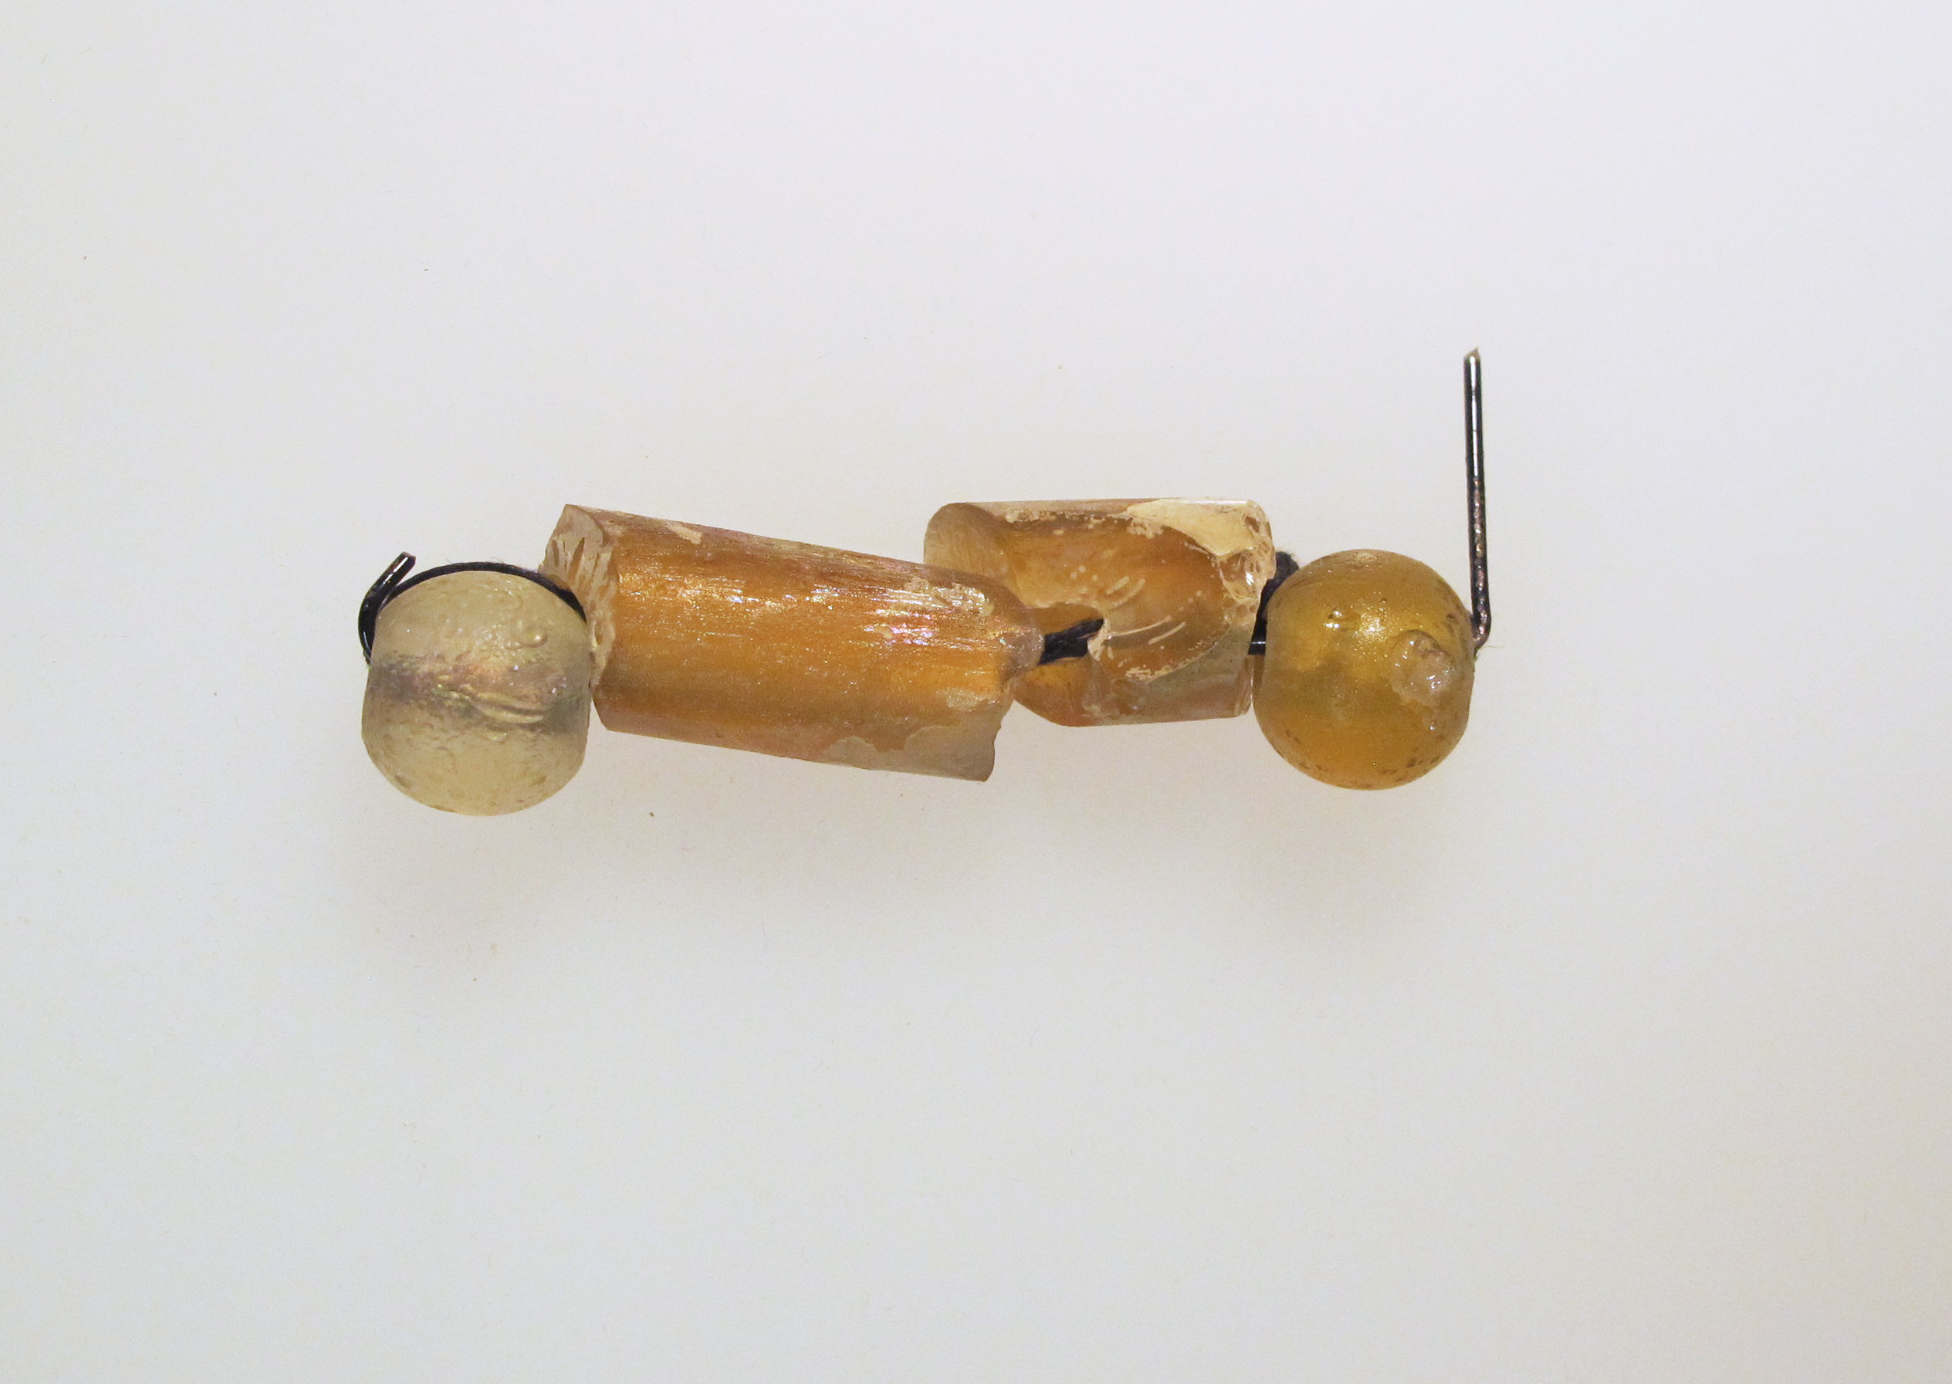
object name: bead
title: Three beads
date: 7000 BCE-330 CE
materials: glass